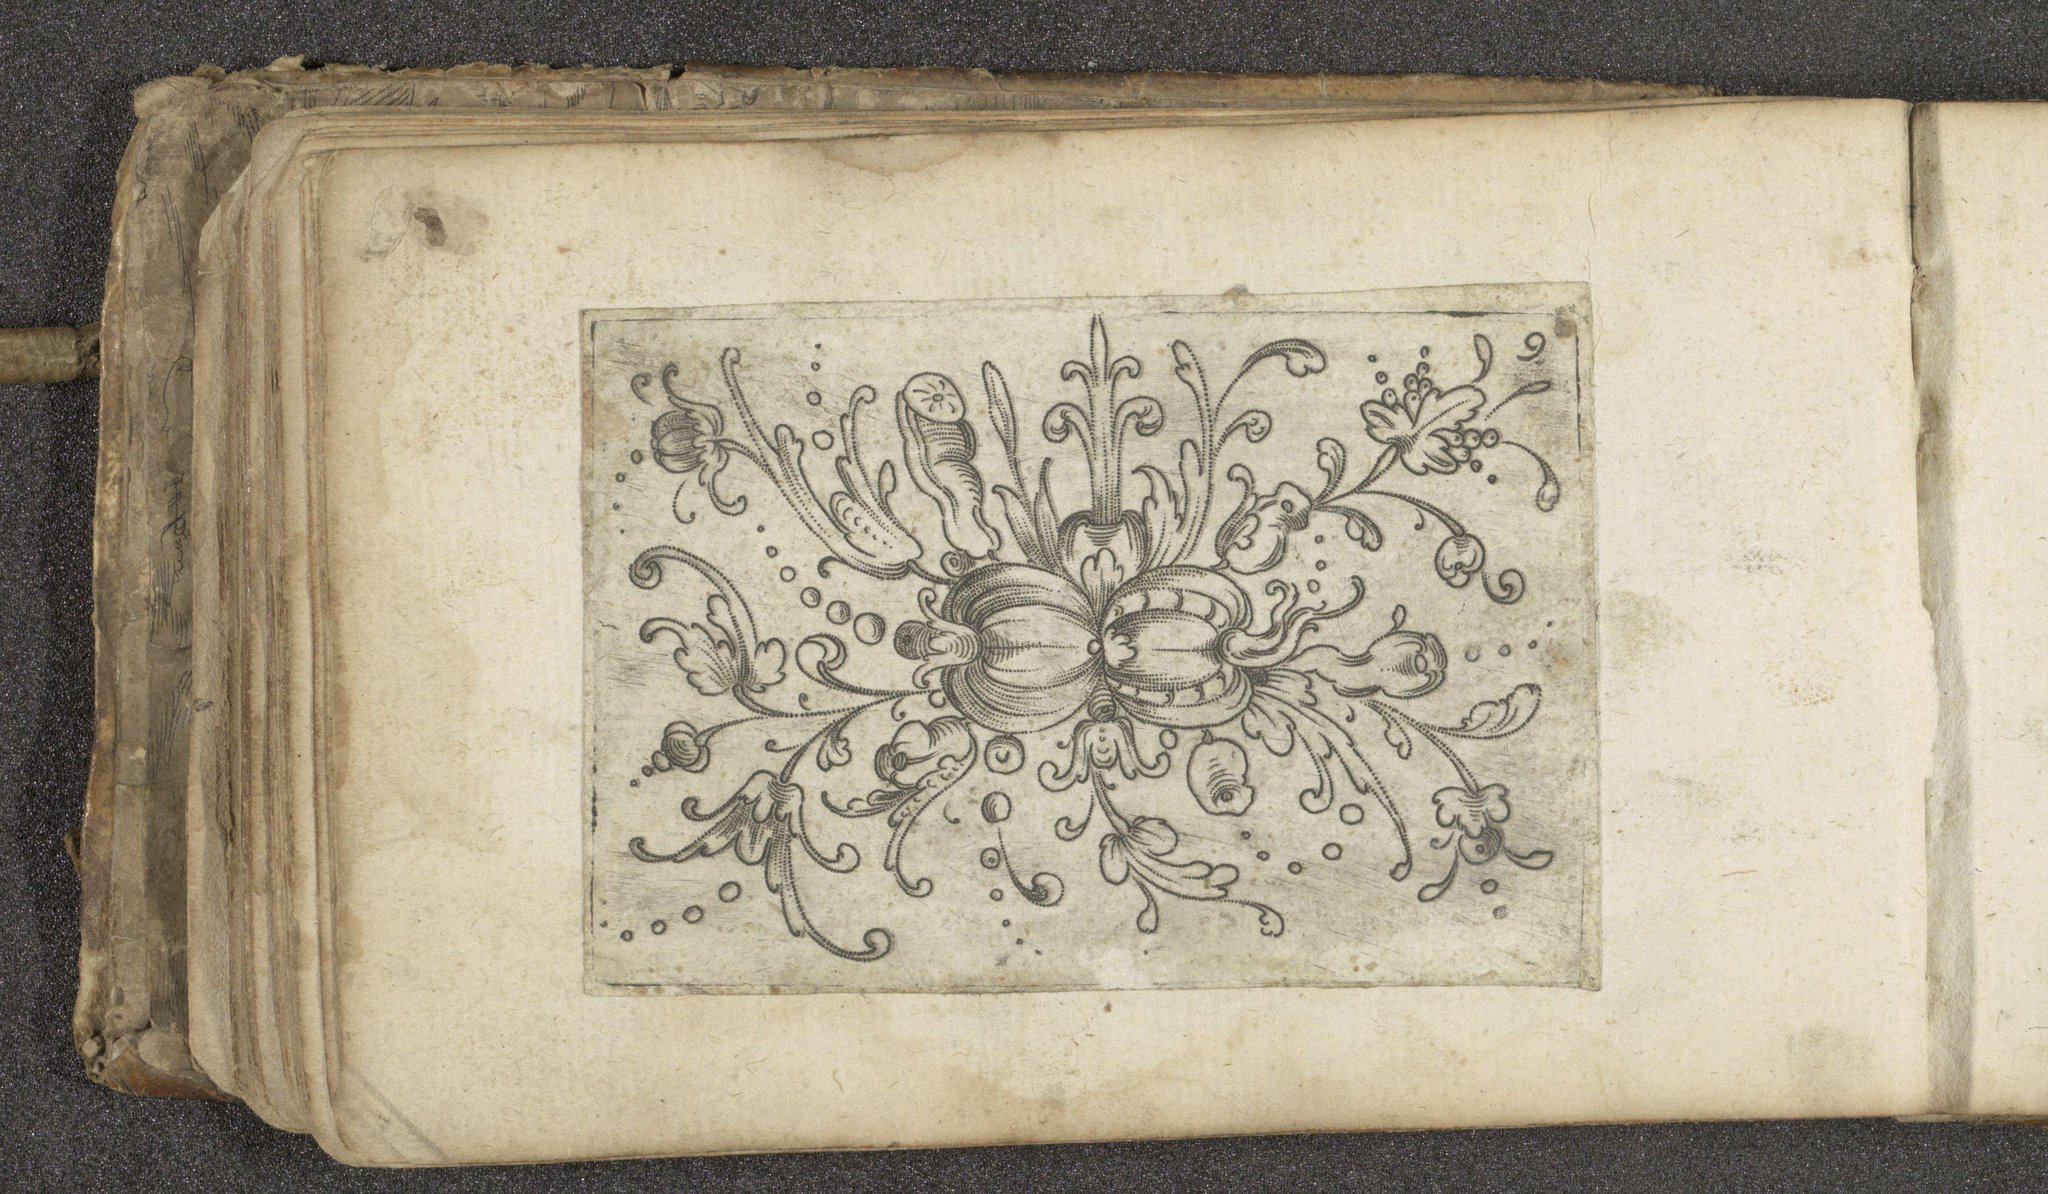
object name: print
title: Vruchtentros met pompoenen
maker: Anonymous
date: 1551-1650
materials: paper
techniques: etching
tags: ornaments ~ art, fruits and vegetables ~ ornament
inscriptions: inscription: ‘47’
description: Ornament met vruchtentros. In het midden twee pompoenen. Linksonder genummerd: 6. De prent maakt deel uit van een album.